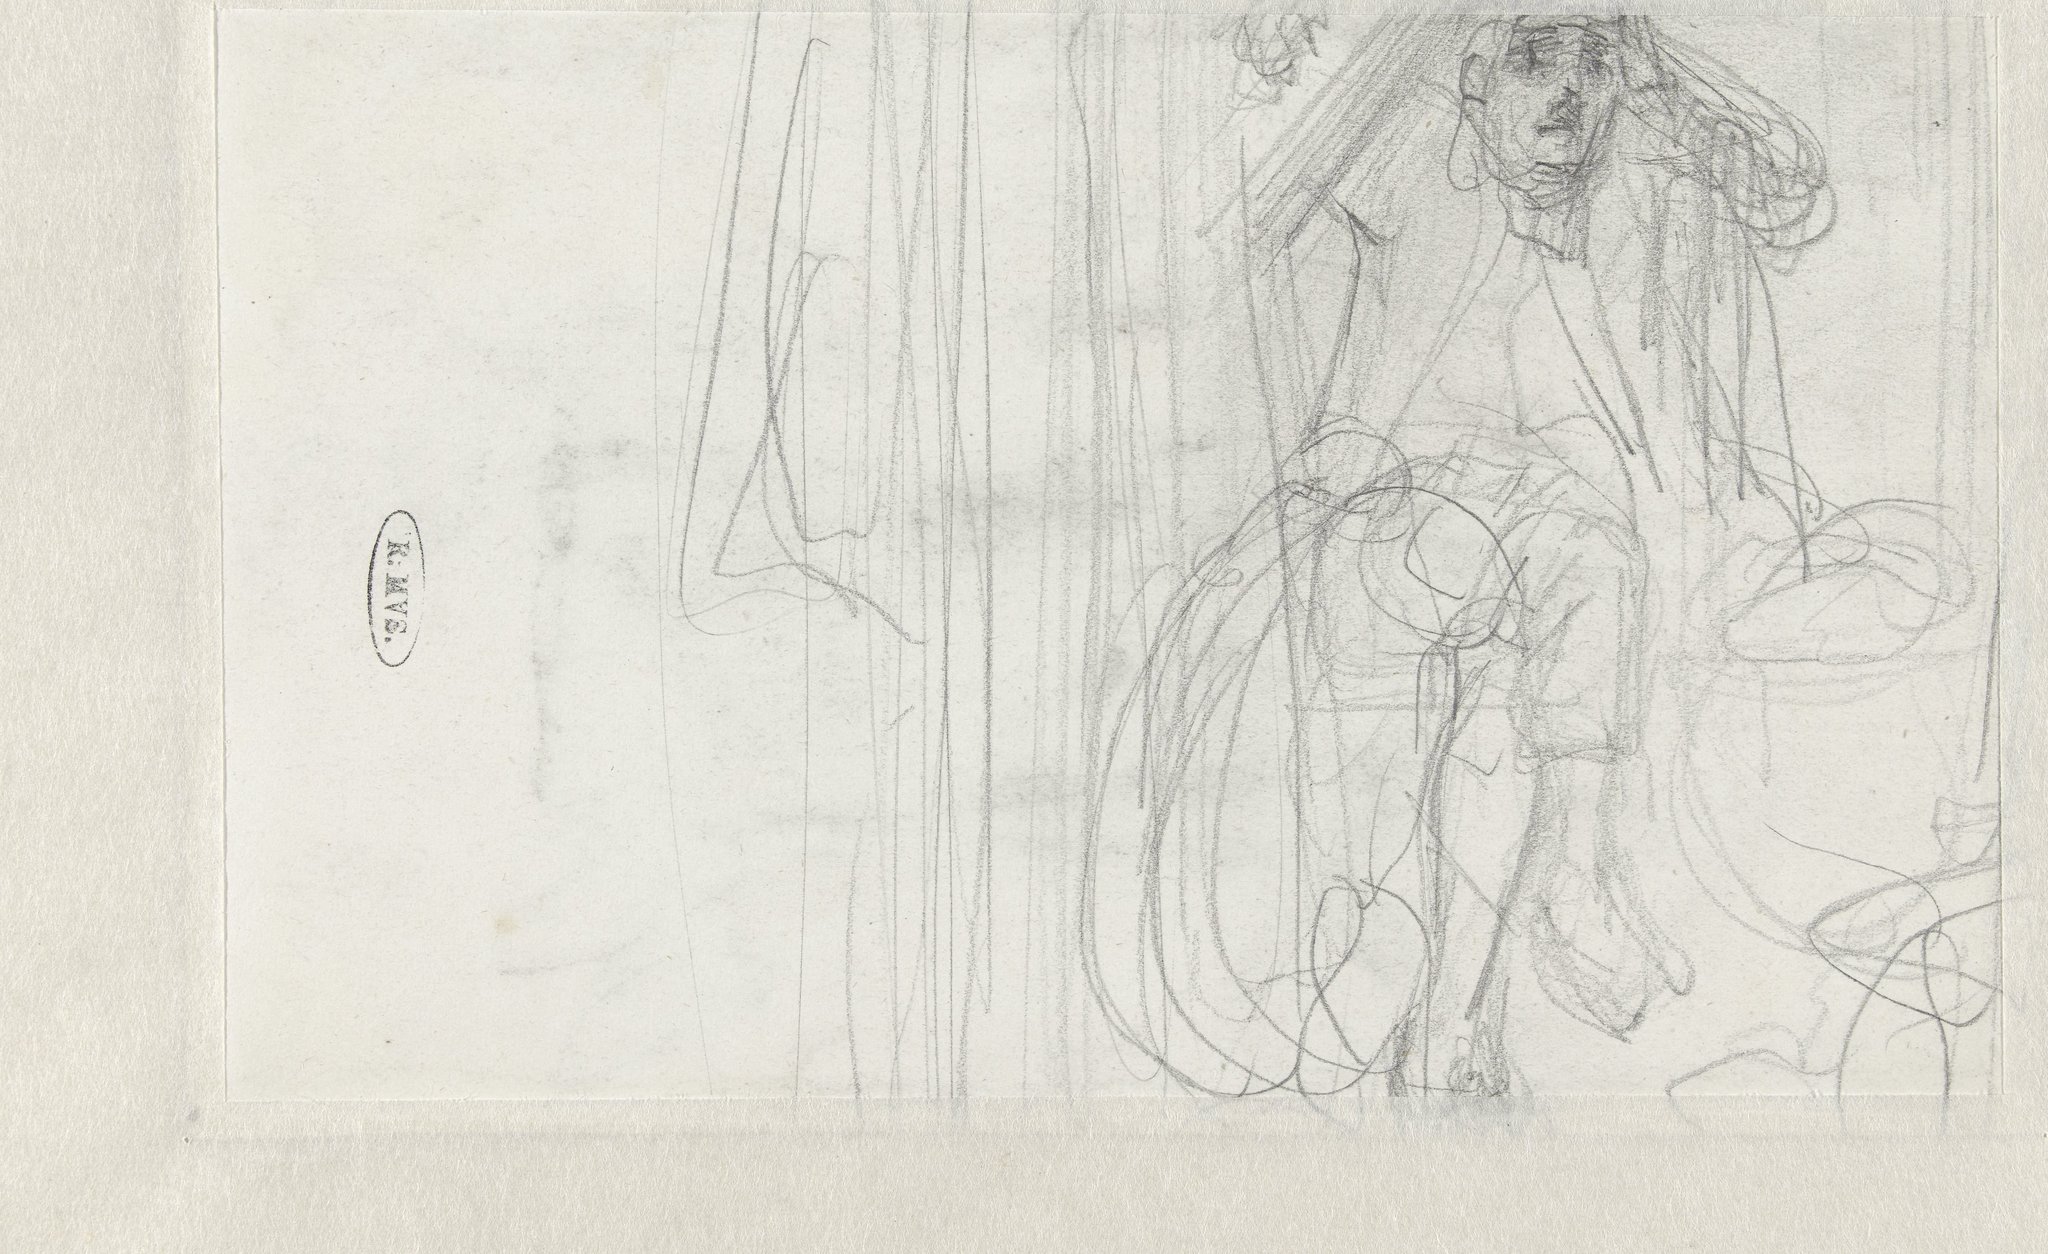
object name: drawing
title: Schets van een zittende man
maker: august allebé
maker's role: draughtsman, print maker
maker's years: 1838-1927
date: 1848-1927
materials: paper, pencil